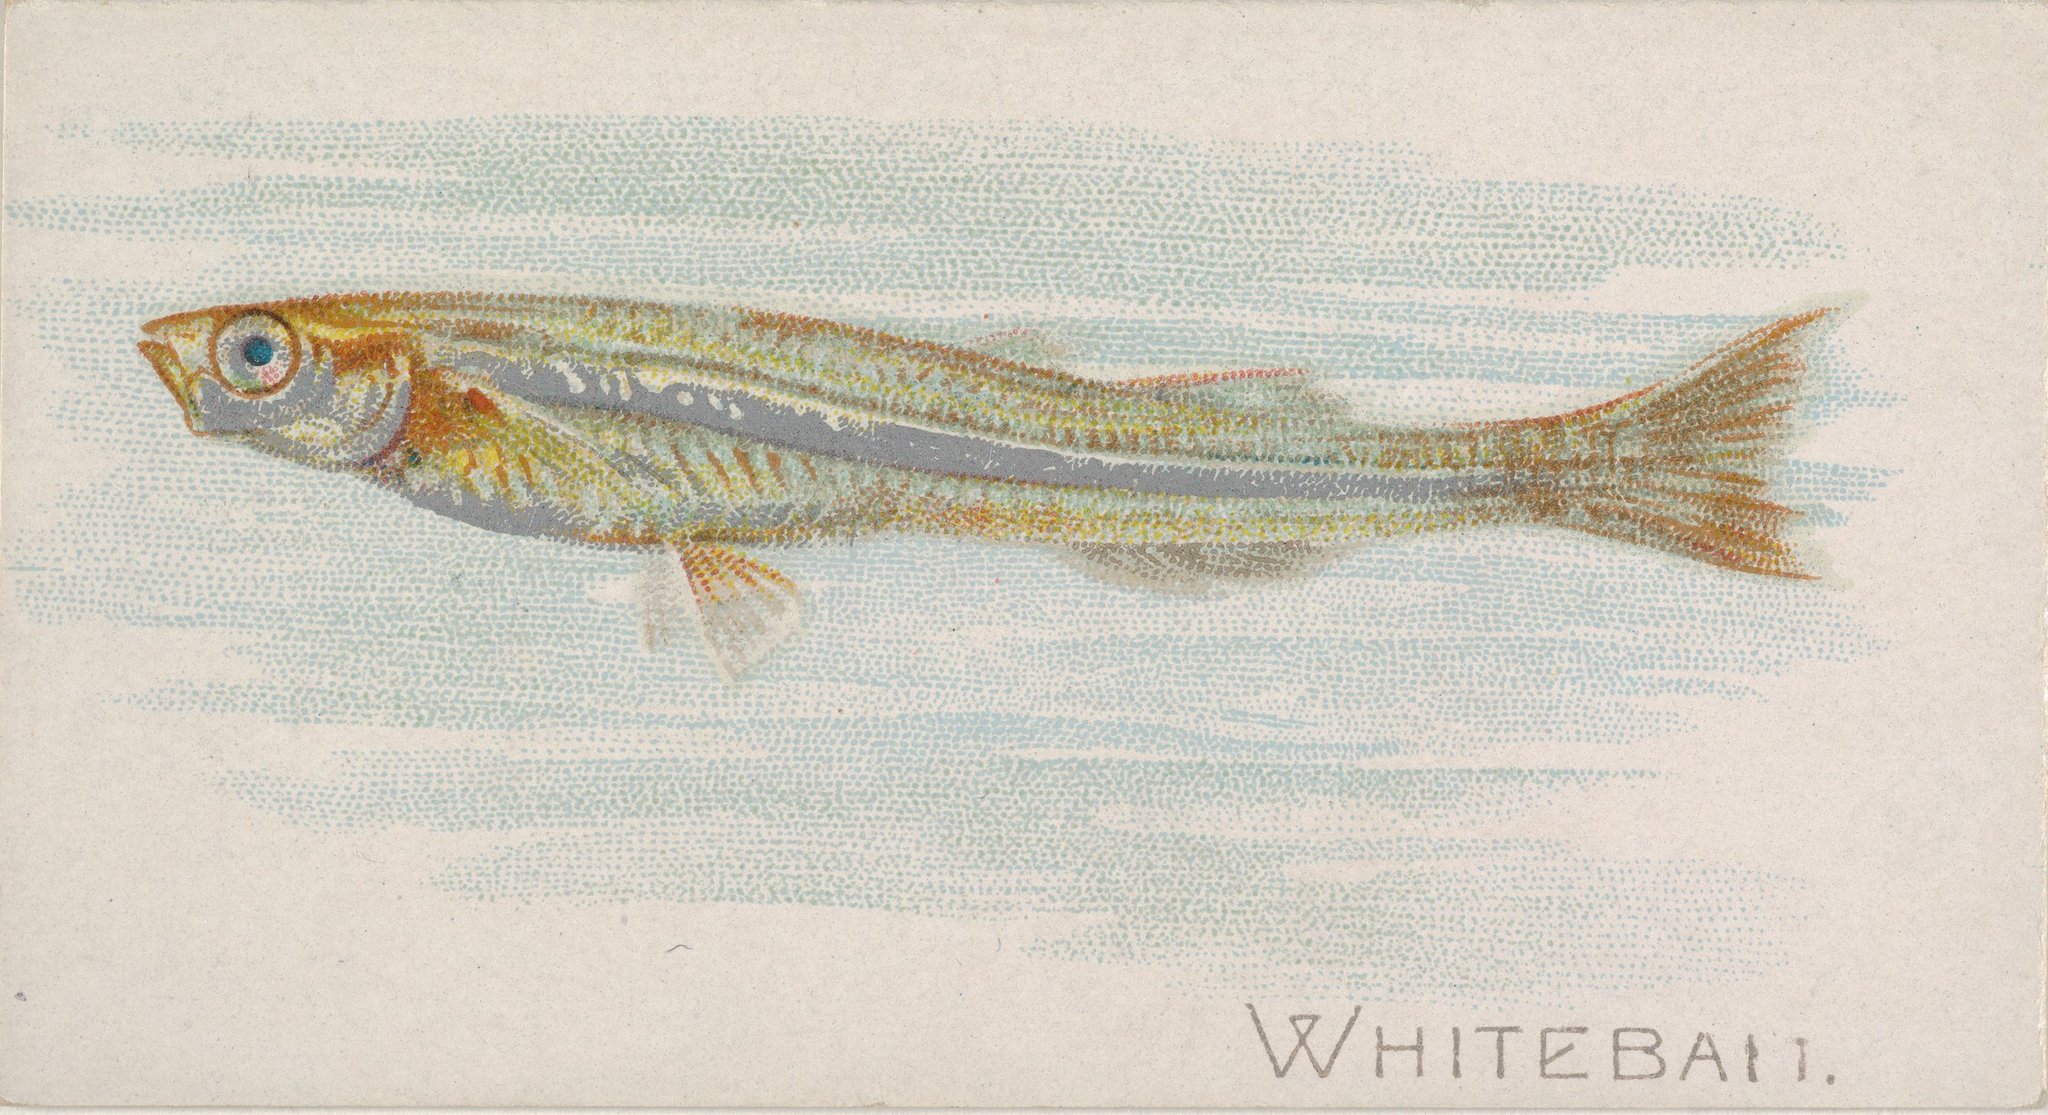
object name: print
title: Whitebait, from the Fish from American Waters series (N8) for Allen & Ginter Cigarettes Brands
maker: allen & ginter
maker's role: publisher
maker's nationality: american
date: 1889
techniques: color lithograph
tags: fish